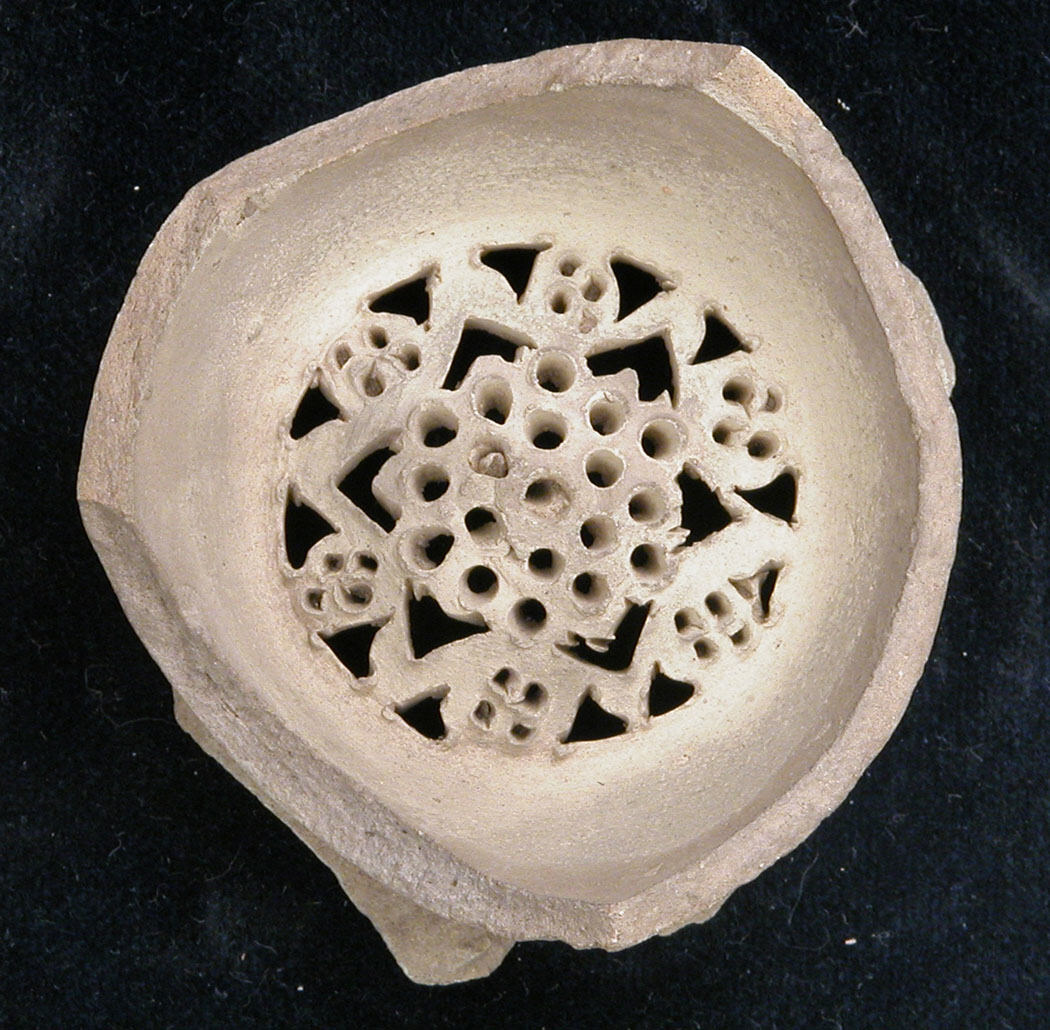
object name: water filter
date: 901-1200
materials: earthenware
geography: egypt